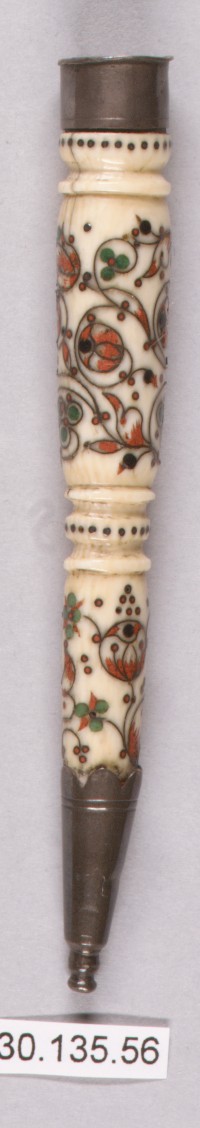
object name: needle sheath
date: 1601-1700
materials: ivory, metal